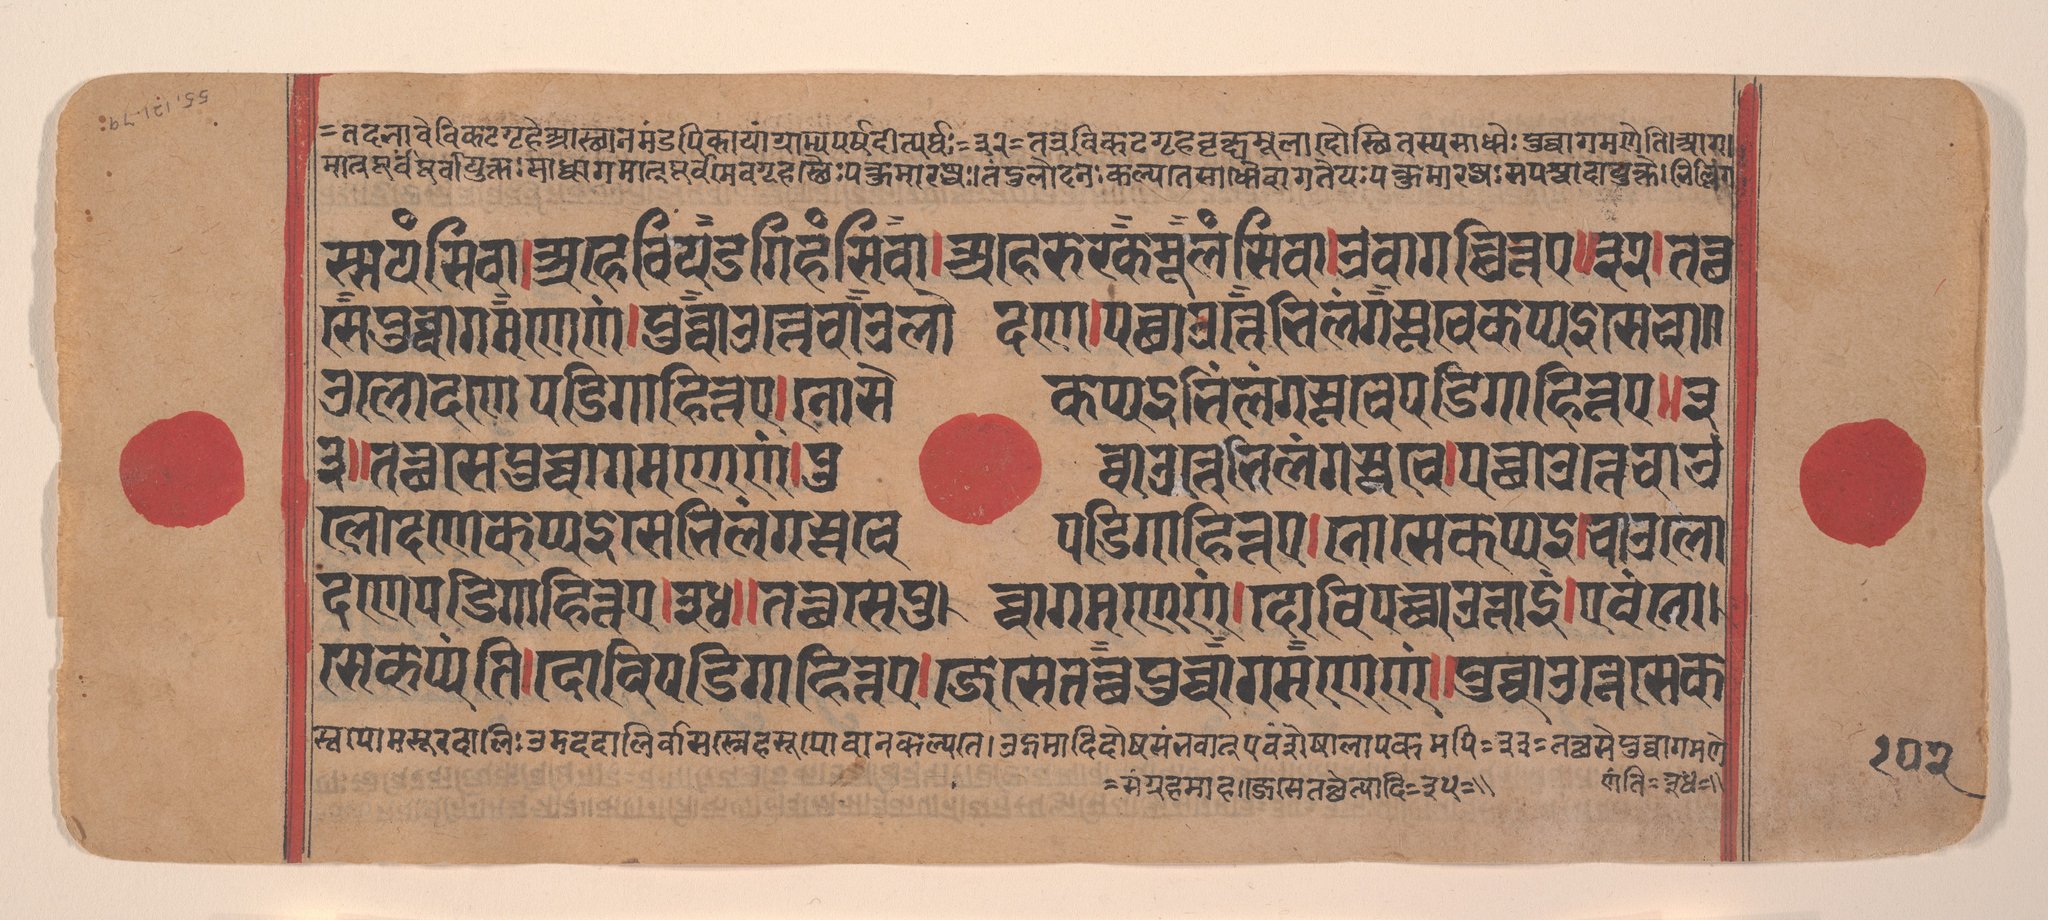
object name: folio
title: Page from a Dispersed Kalpa Sutra (Jain Book of Rituals)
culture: indian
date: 1401-1500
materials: gold, ink, paper, watercolor